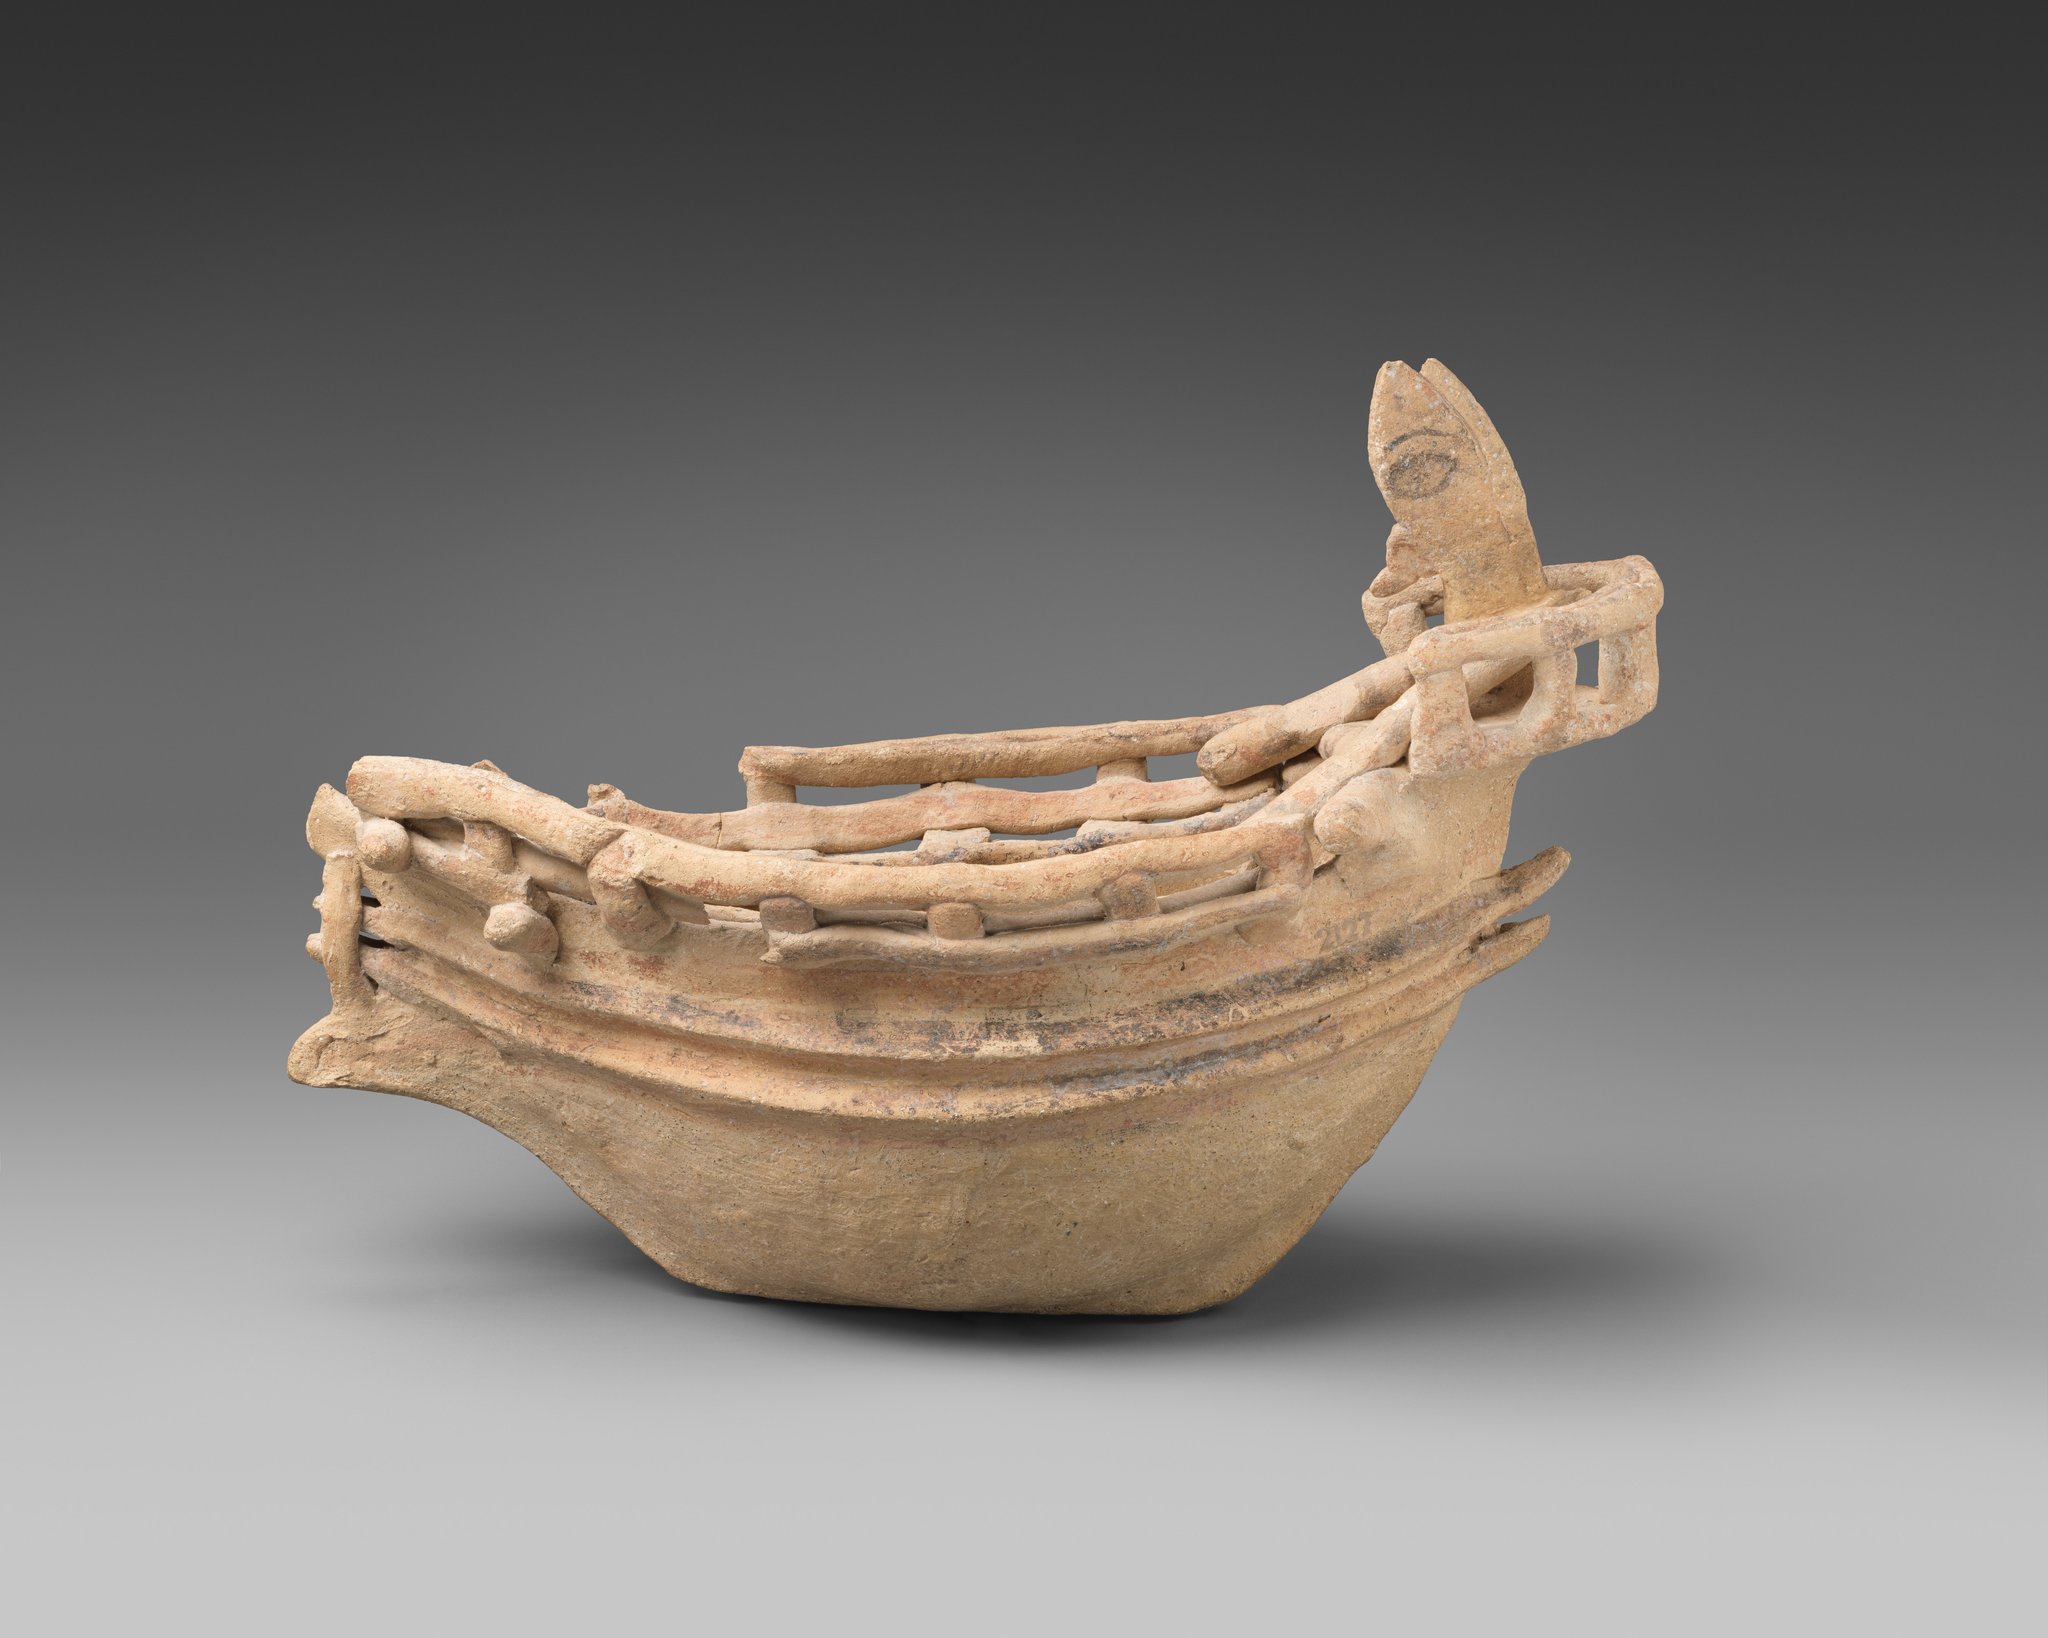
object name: model of a ship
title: Terracotta model of a ship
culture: cypriot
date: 600-480 BCE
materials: terracotta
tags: ships